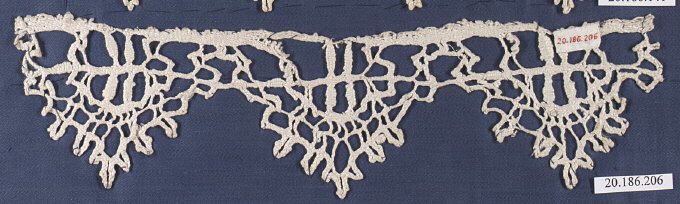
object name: edging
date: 1601-1700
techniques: lace